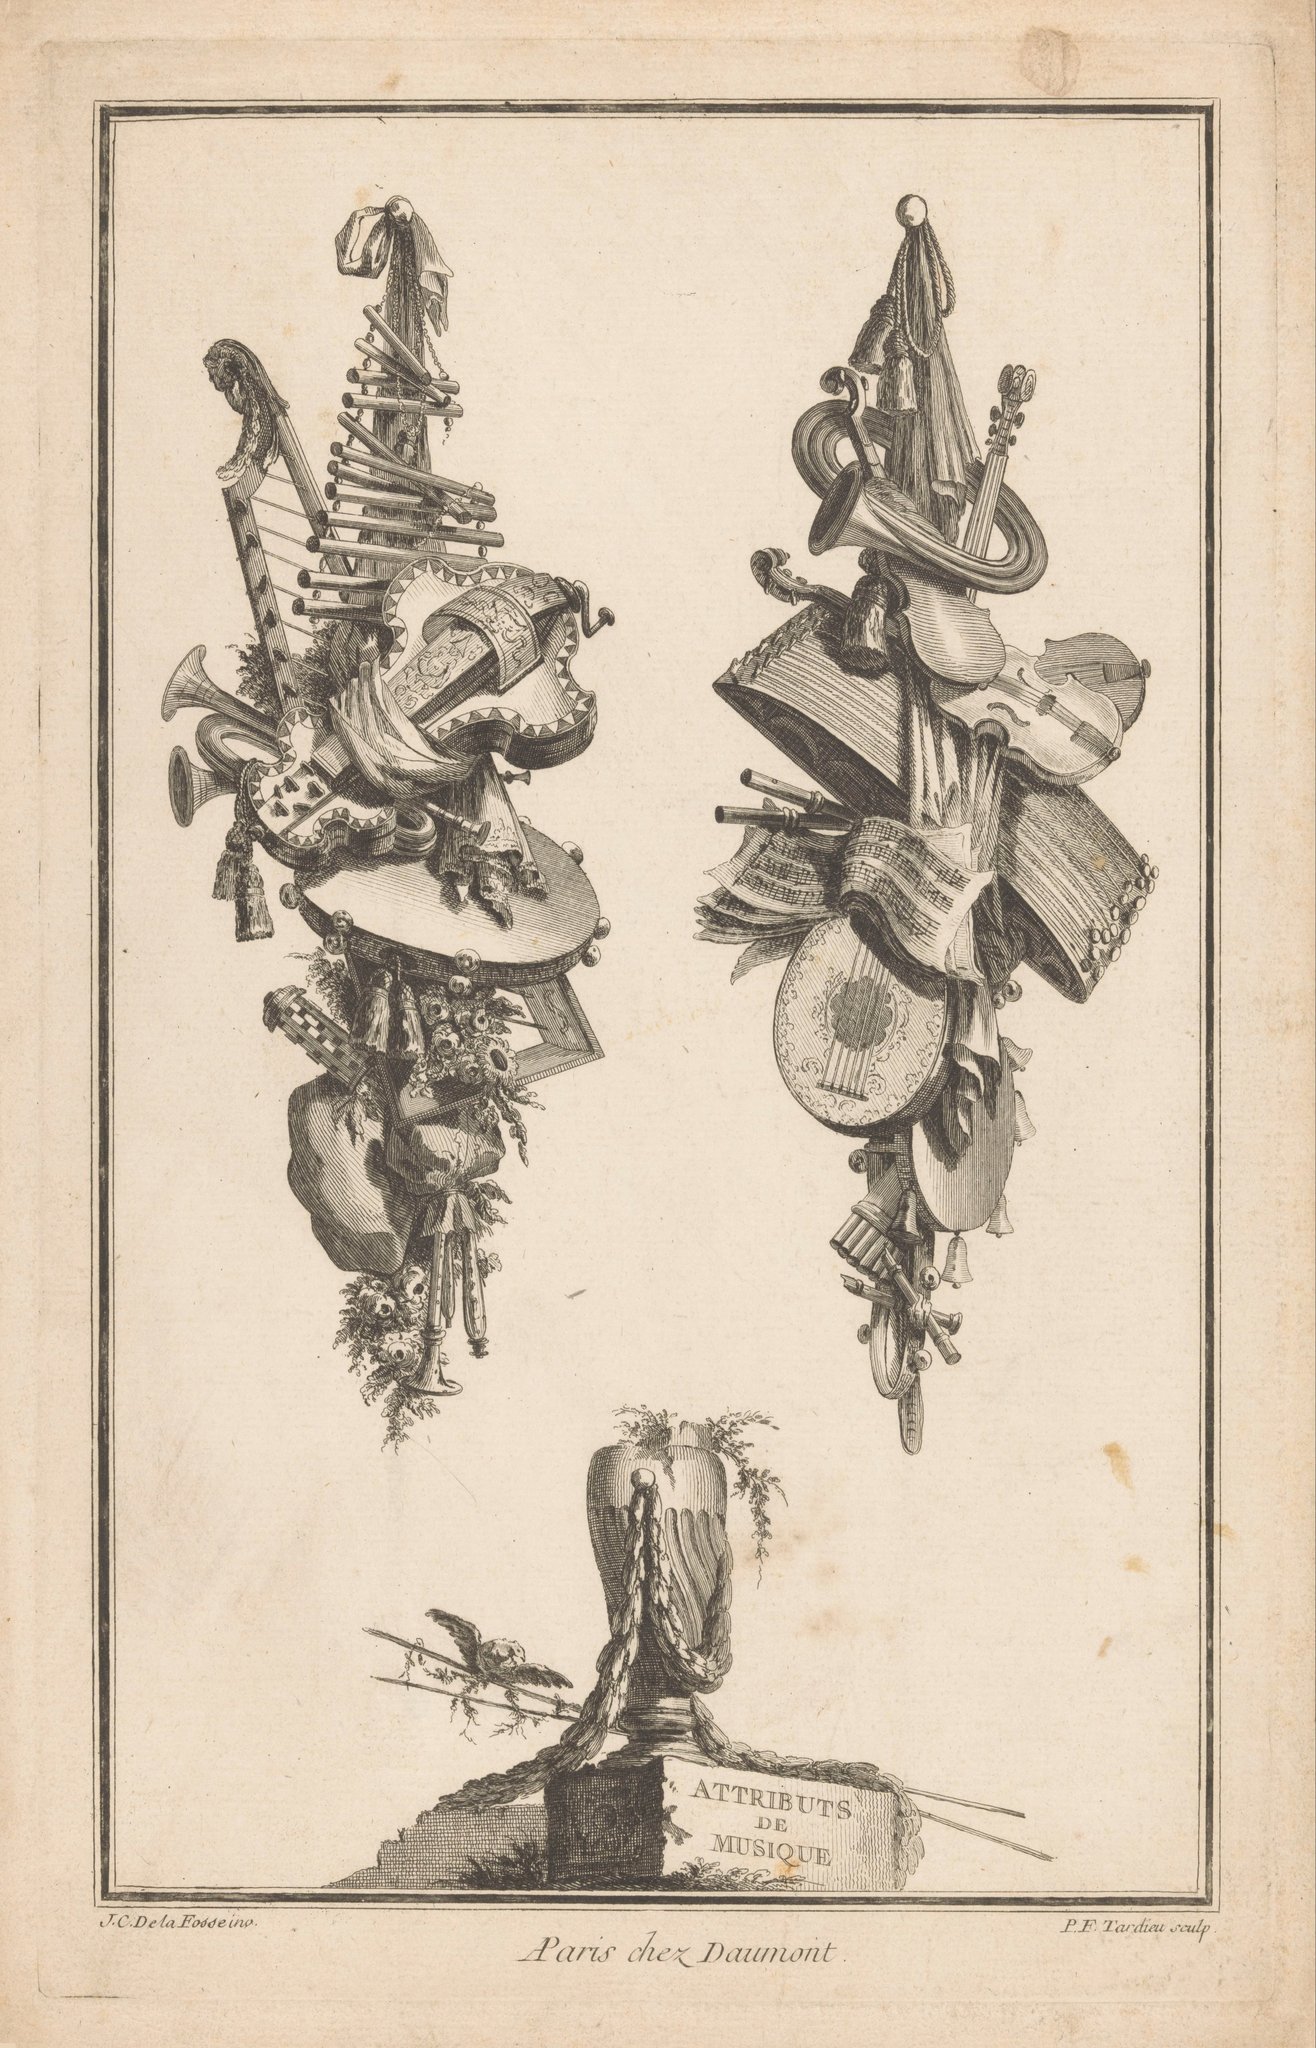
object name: ornament print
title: Attributs De Musique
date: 1771-1775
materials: paper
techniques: engraving, etching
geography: paris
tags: trophy, i.e.: decorative arrangement of symbolic or typical objects ~ ornament, 'musica', symbolic representations, allegories and emblems ~ music; 'musica'(ripa)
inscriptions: collector's mark: Lugt 2760, collector's mark: Lugt 2228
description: Twee trofeeën met bladmuziek en muziekinstrumenten zoals een xylofoon, een tamboerijn, een hoorn, violen en een luit.